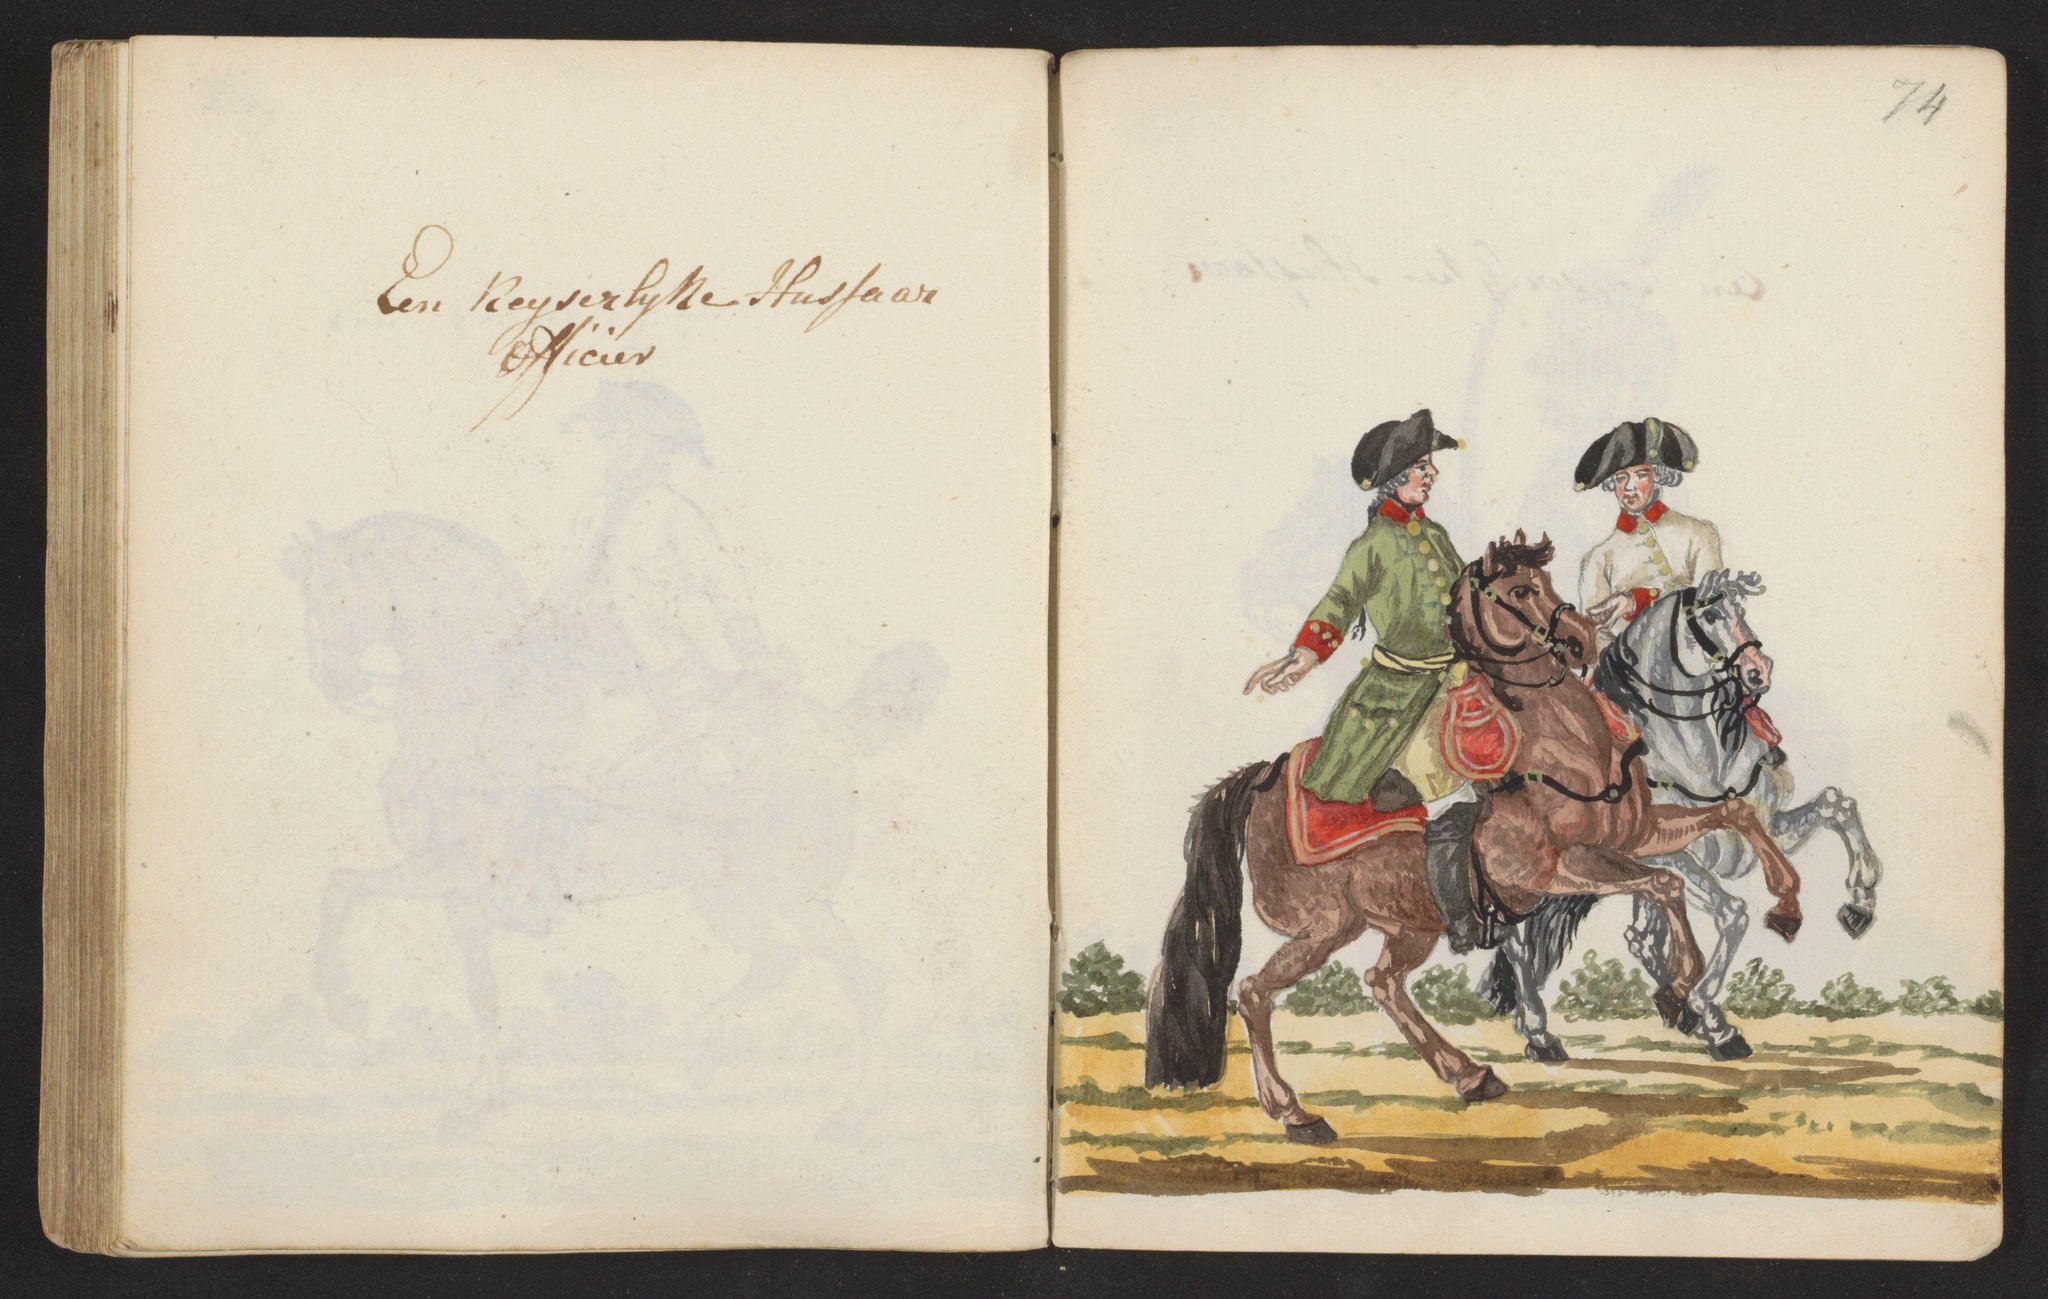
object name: drawing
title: Een Keyserlyke Hussaar officier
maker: s.g. casten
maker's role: draughtsman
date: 1795-1796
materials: paper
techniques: writing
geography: amsterdam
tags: (military) uniforms (+ infantry), patriots (1780-1795)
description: De uniformen van twee officieren van de Oostenrijkse keizerlijke troepen, te paard, ca. 1788-1795. De bladzijde met de tekst correleert niet met de bladzijde met de voorstelling. Hier is blad uit het album gescheurd. Onderdeel van het derde hoofdstuk over de nieuwe uniformen in de periode na het herstel van de prins van Oranje en de komst van de Pruisische troepen in Holland in 1787. In het schetsboek met gekleurde tekeningen van de uniformen van militairen en leden van de schutterij uit de periode 1770 tot 1795-1796.